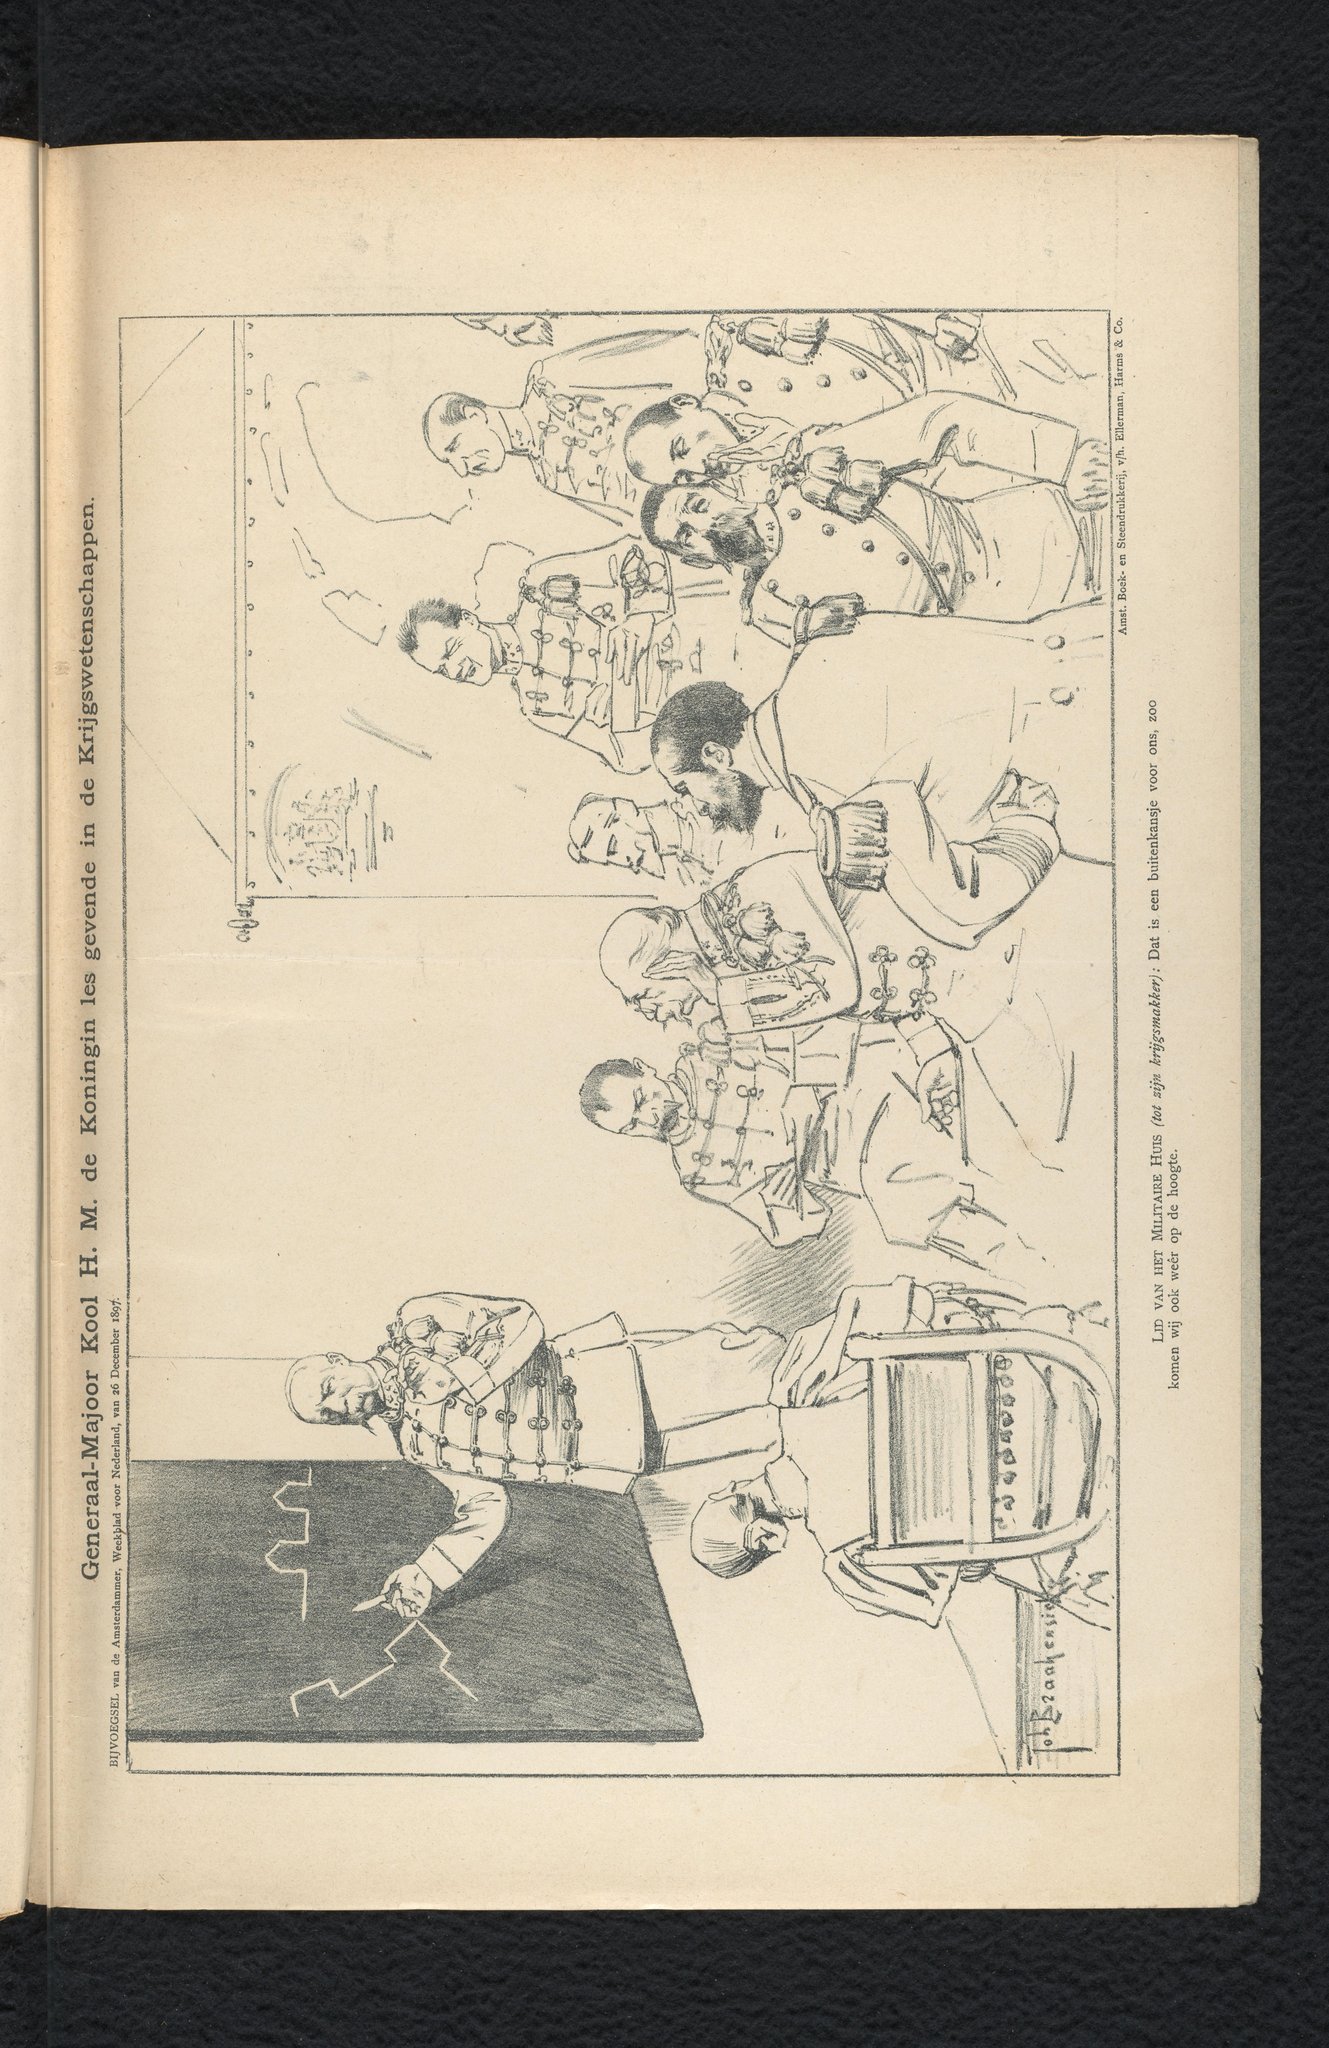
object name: cartoon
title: Generaal-Majoor Kool H.M. de Koningin les gevende in de Krijgswetenschappen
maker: johan braakensiek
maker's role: draughtsman, print maker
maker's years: 1858-1940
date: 1897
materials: paper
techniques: lithograph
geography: amsterdam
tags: the hague, print maker, wilhelmina of the netherlands, further education, military instruction, political caricatures and satires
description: Minister van oorlog Arthur Kool geeft les in de krijgswetenschappen aan de jonge koningin Wilhelmina. Ook de aanwezige leden van de generale staf steken er wat van op.